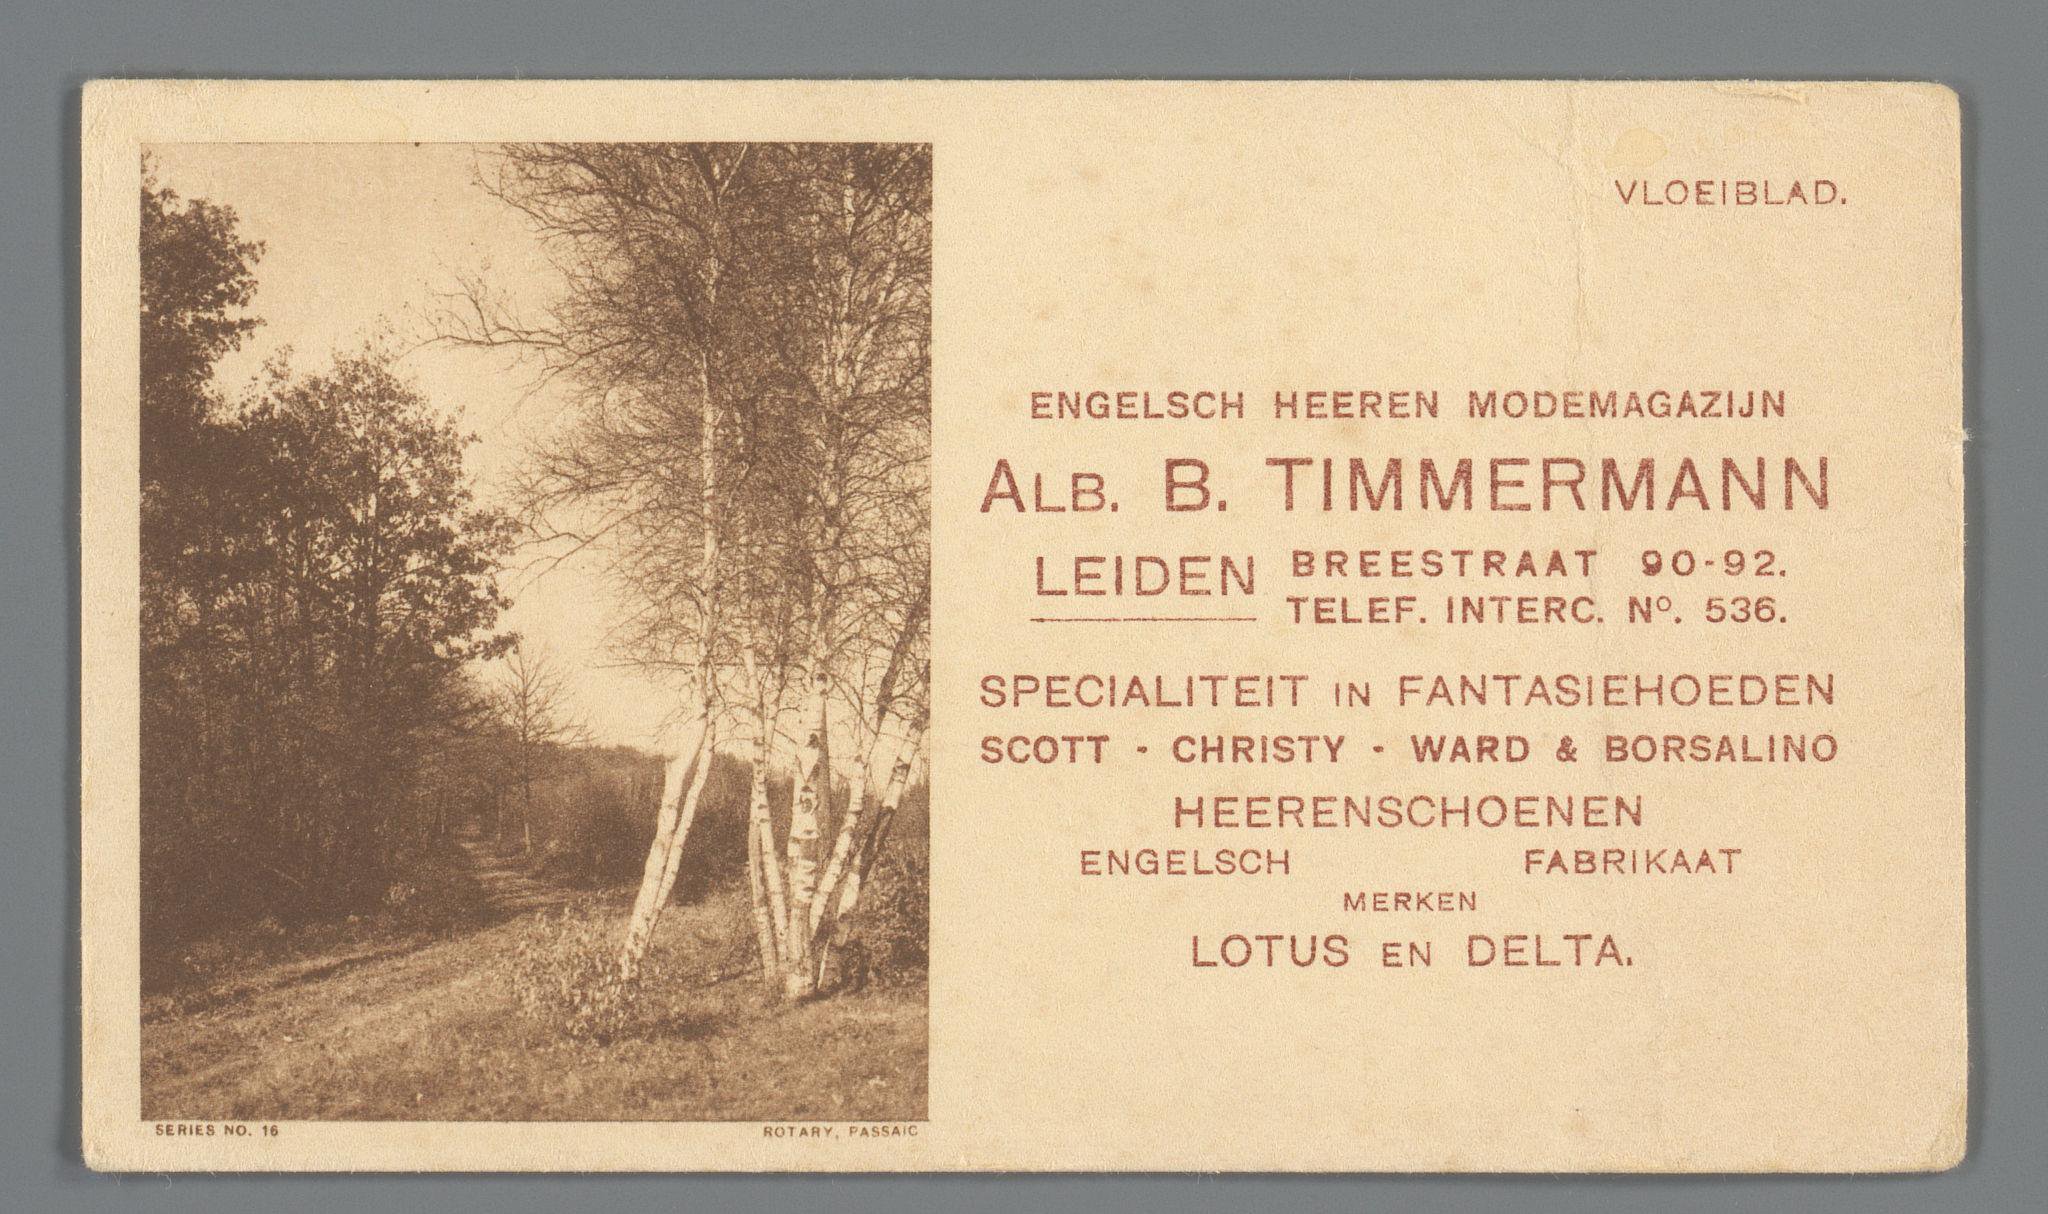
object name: vloeiblad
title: Visitekaart van 'Engelsch heeren modemagazijn Alb. B. Timmermann' te Leiden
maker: Anonymous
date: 1900-1940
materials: paper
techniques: photograph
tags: forest, wood, trees: birch, leiden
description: Links een landschap met bomen. Rechts de tekst over de kledingwinkel, 'Specialiteit in fantasiehoeden, Scott - Christy - Ward & Borsalino. Heerenschoenen Engelsch fabrikaat merken Lotus en Delta'. Deze kaart diende tevens als vloeiblad. Onder de afbeelding staat vermeld: 'Series no. 16 - Rotary, Passaic'.